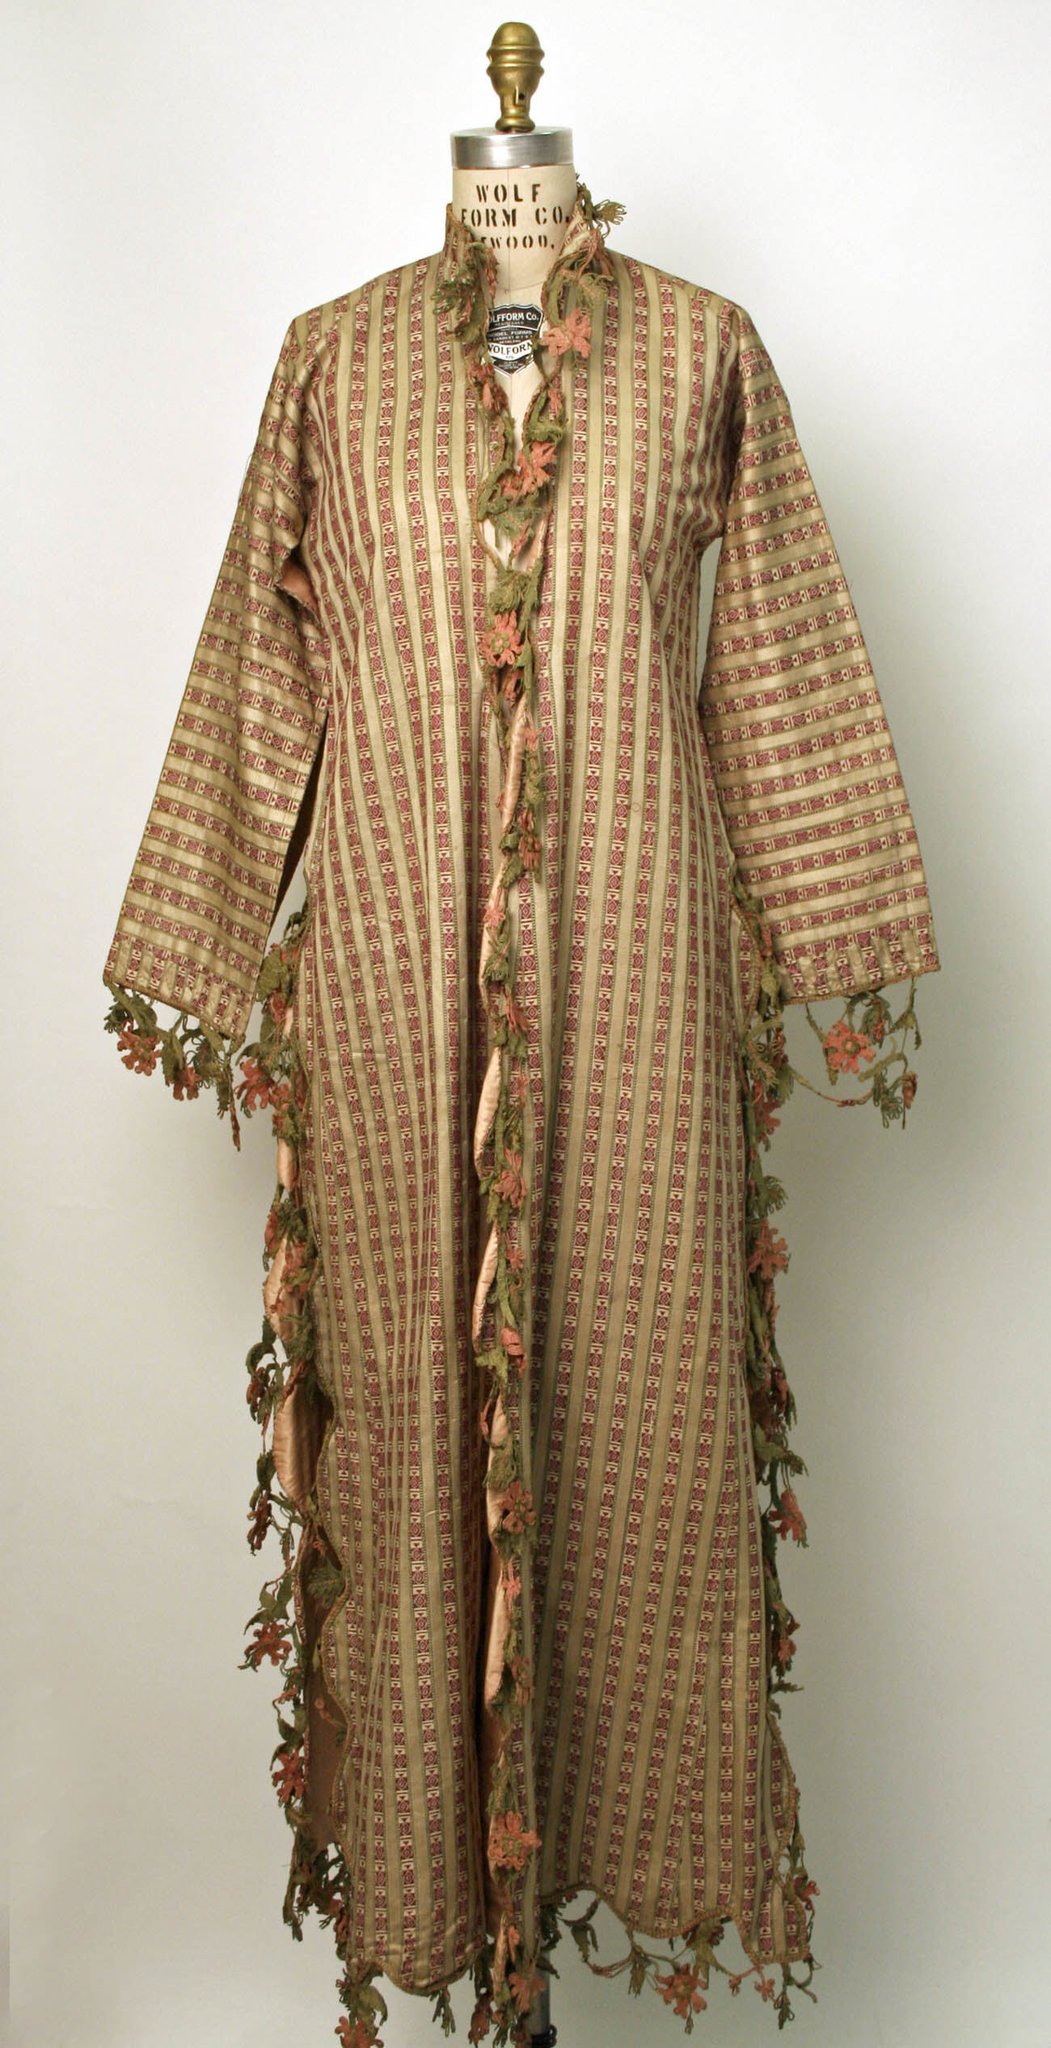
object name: robe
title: Dort Etek Entari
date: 1701-1900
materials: silk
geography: turkey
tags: flowers